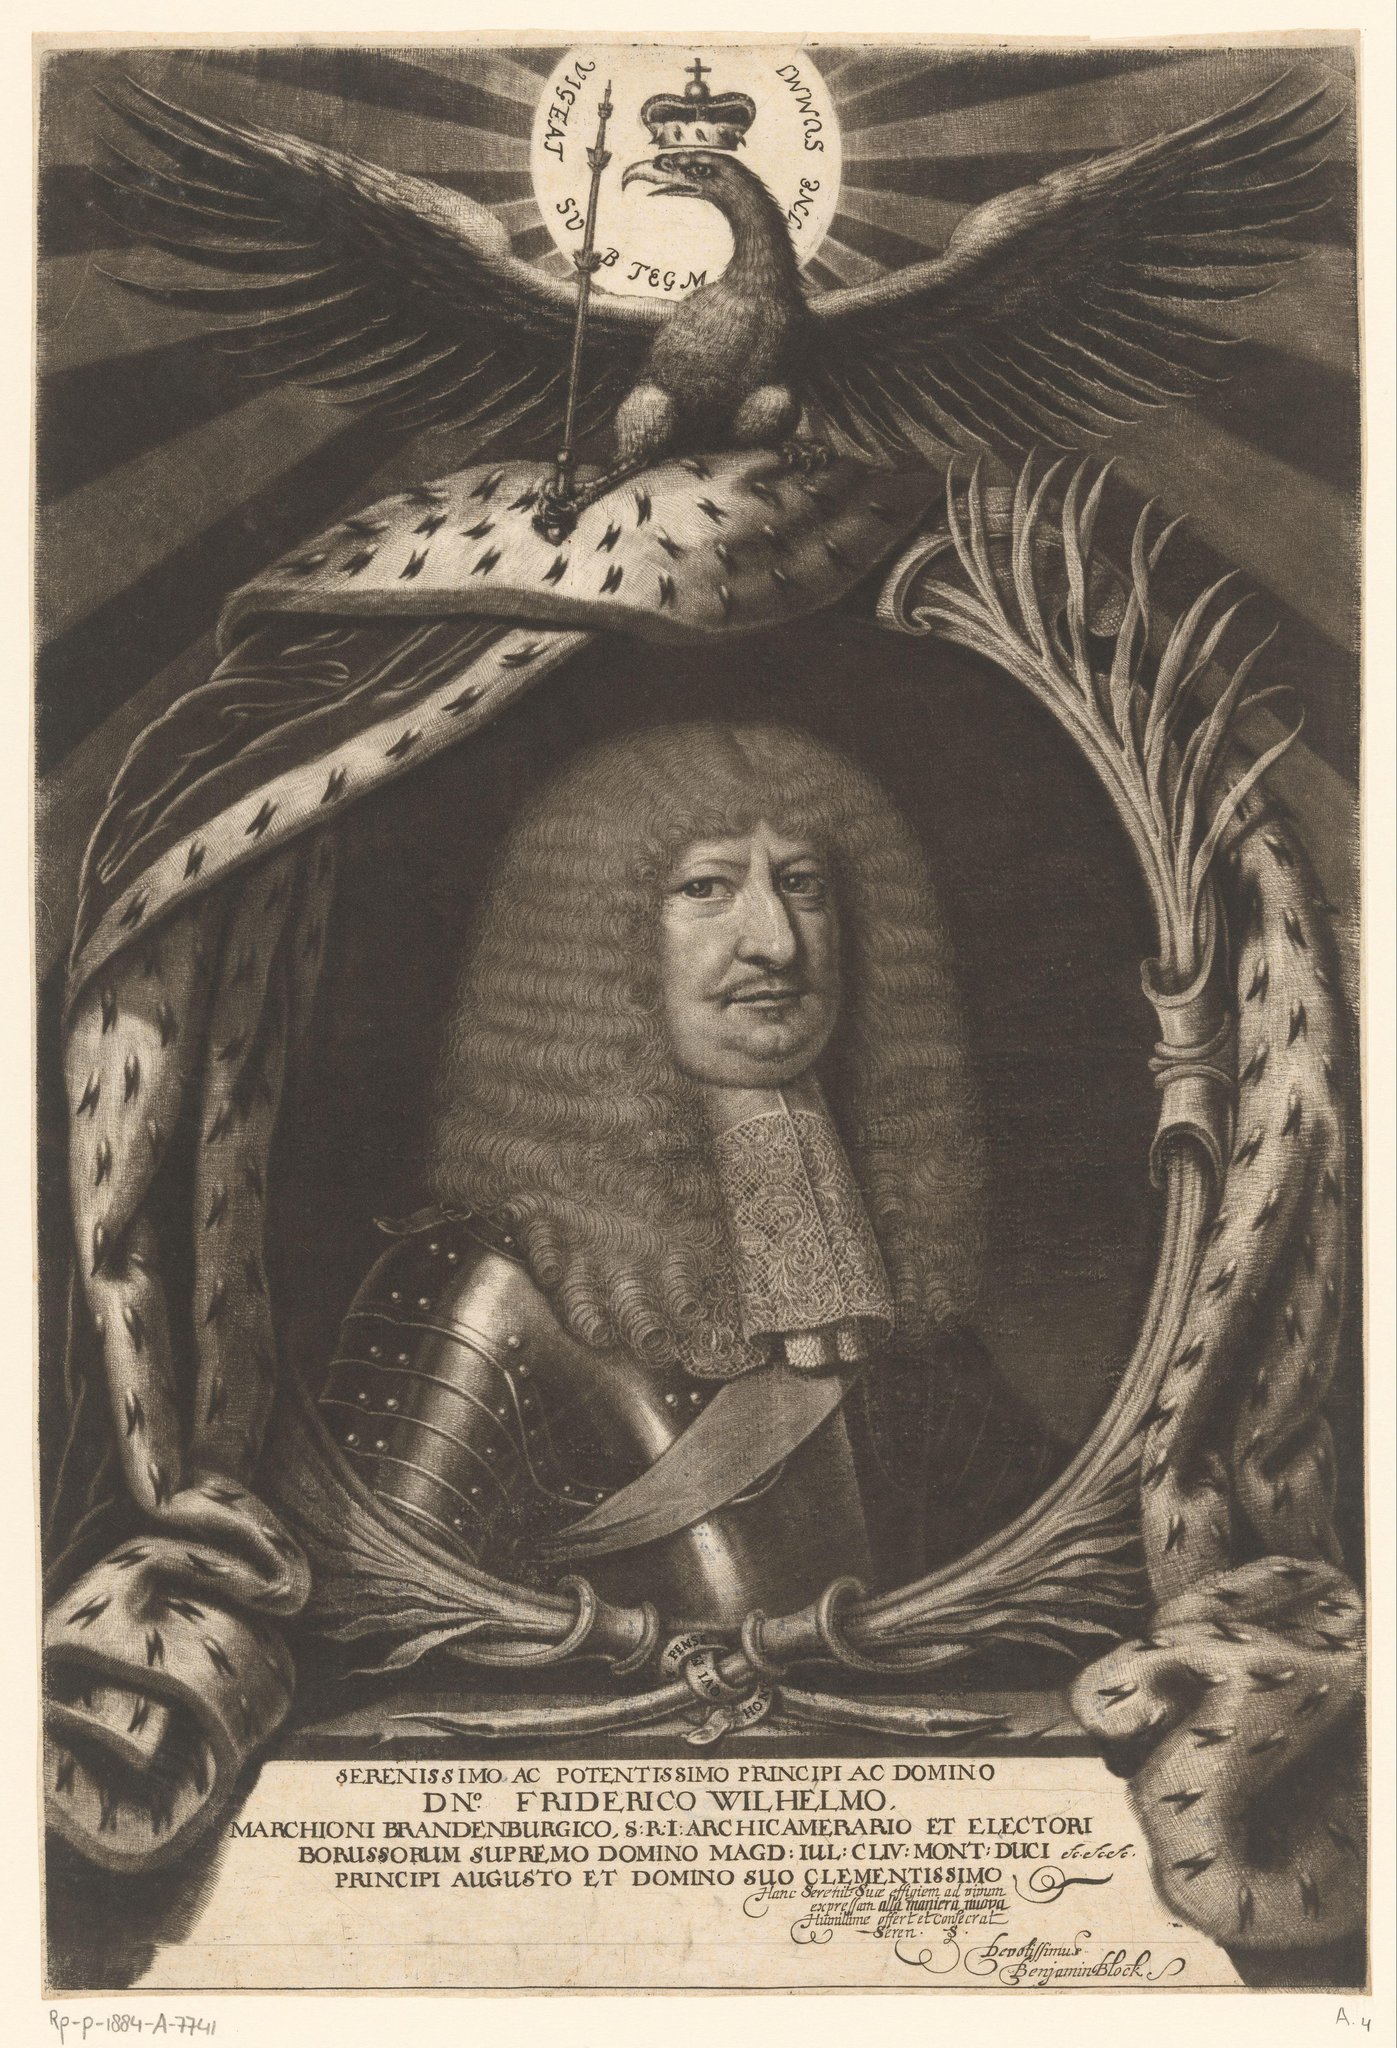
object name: print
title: Portret van Friedrich Wilhelm van Brandenburg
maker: benjamin von block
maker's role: painter, print maker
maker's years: 1631-1690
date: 1642-1690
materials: paper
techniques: roulette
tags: frederik willem van brandenburg (i), predatory birds: eagle, historical persons, ruler, sovereign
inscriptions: inscription: ‘J. A. Boer[...] 1840 [...]’, collector's mark: Lugt 2228, inscription